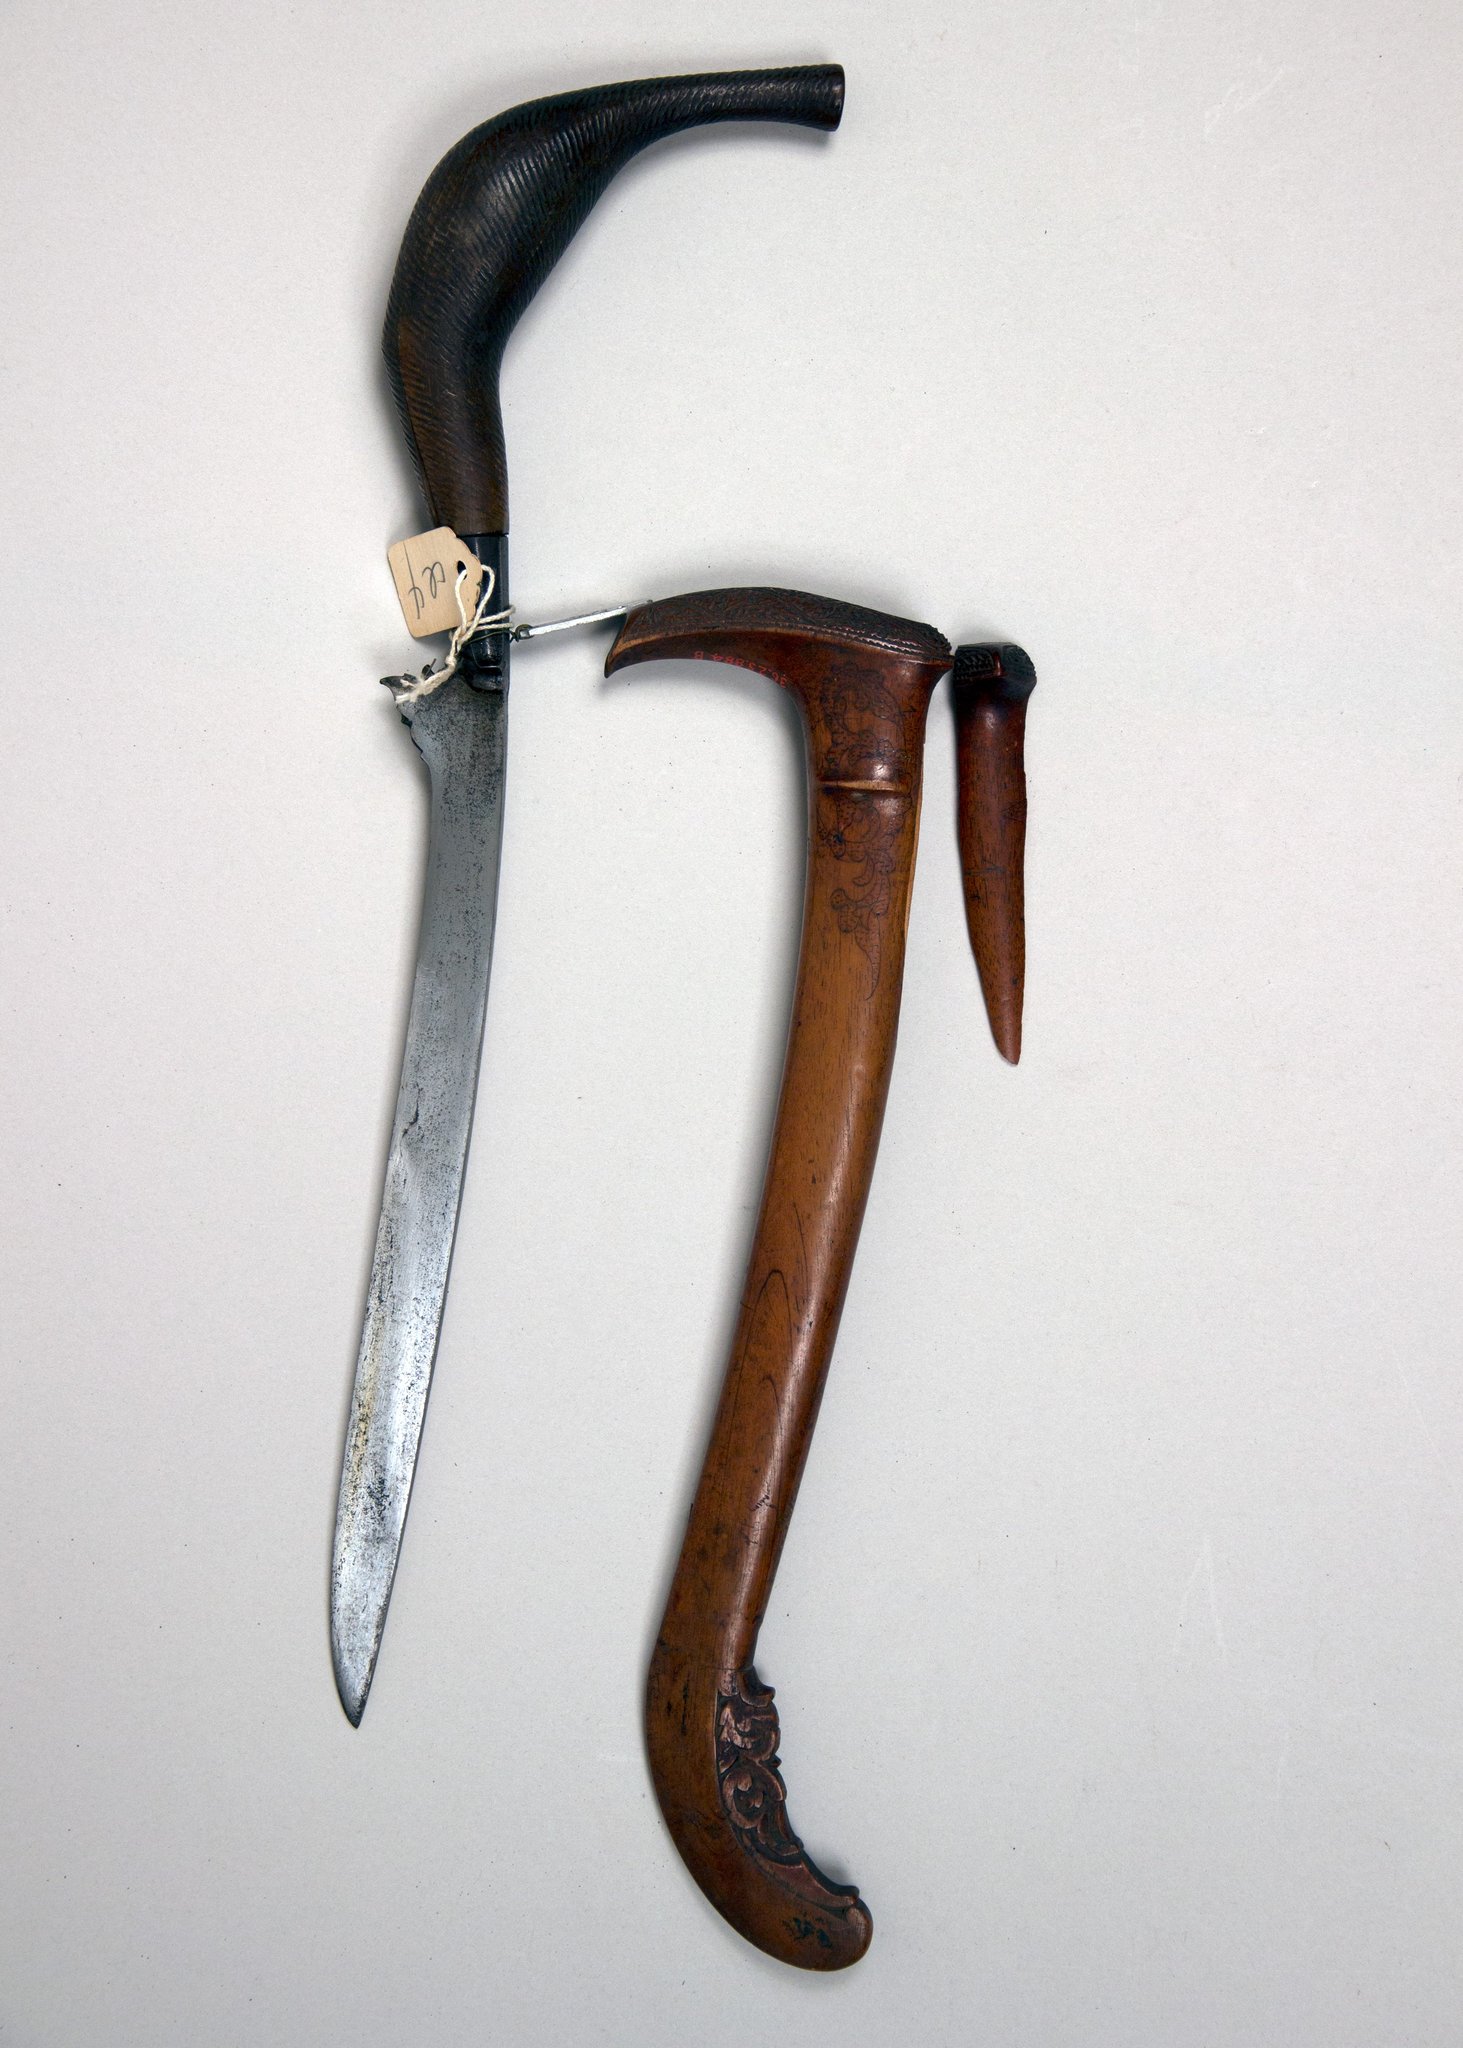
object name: knife bade bade with sheath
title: Knife (Bade-bade) with Sheath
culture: sumatran or acheen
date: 1501-1900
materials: horn, wood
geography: indonesia